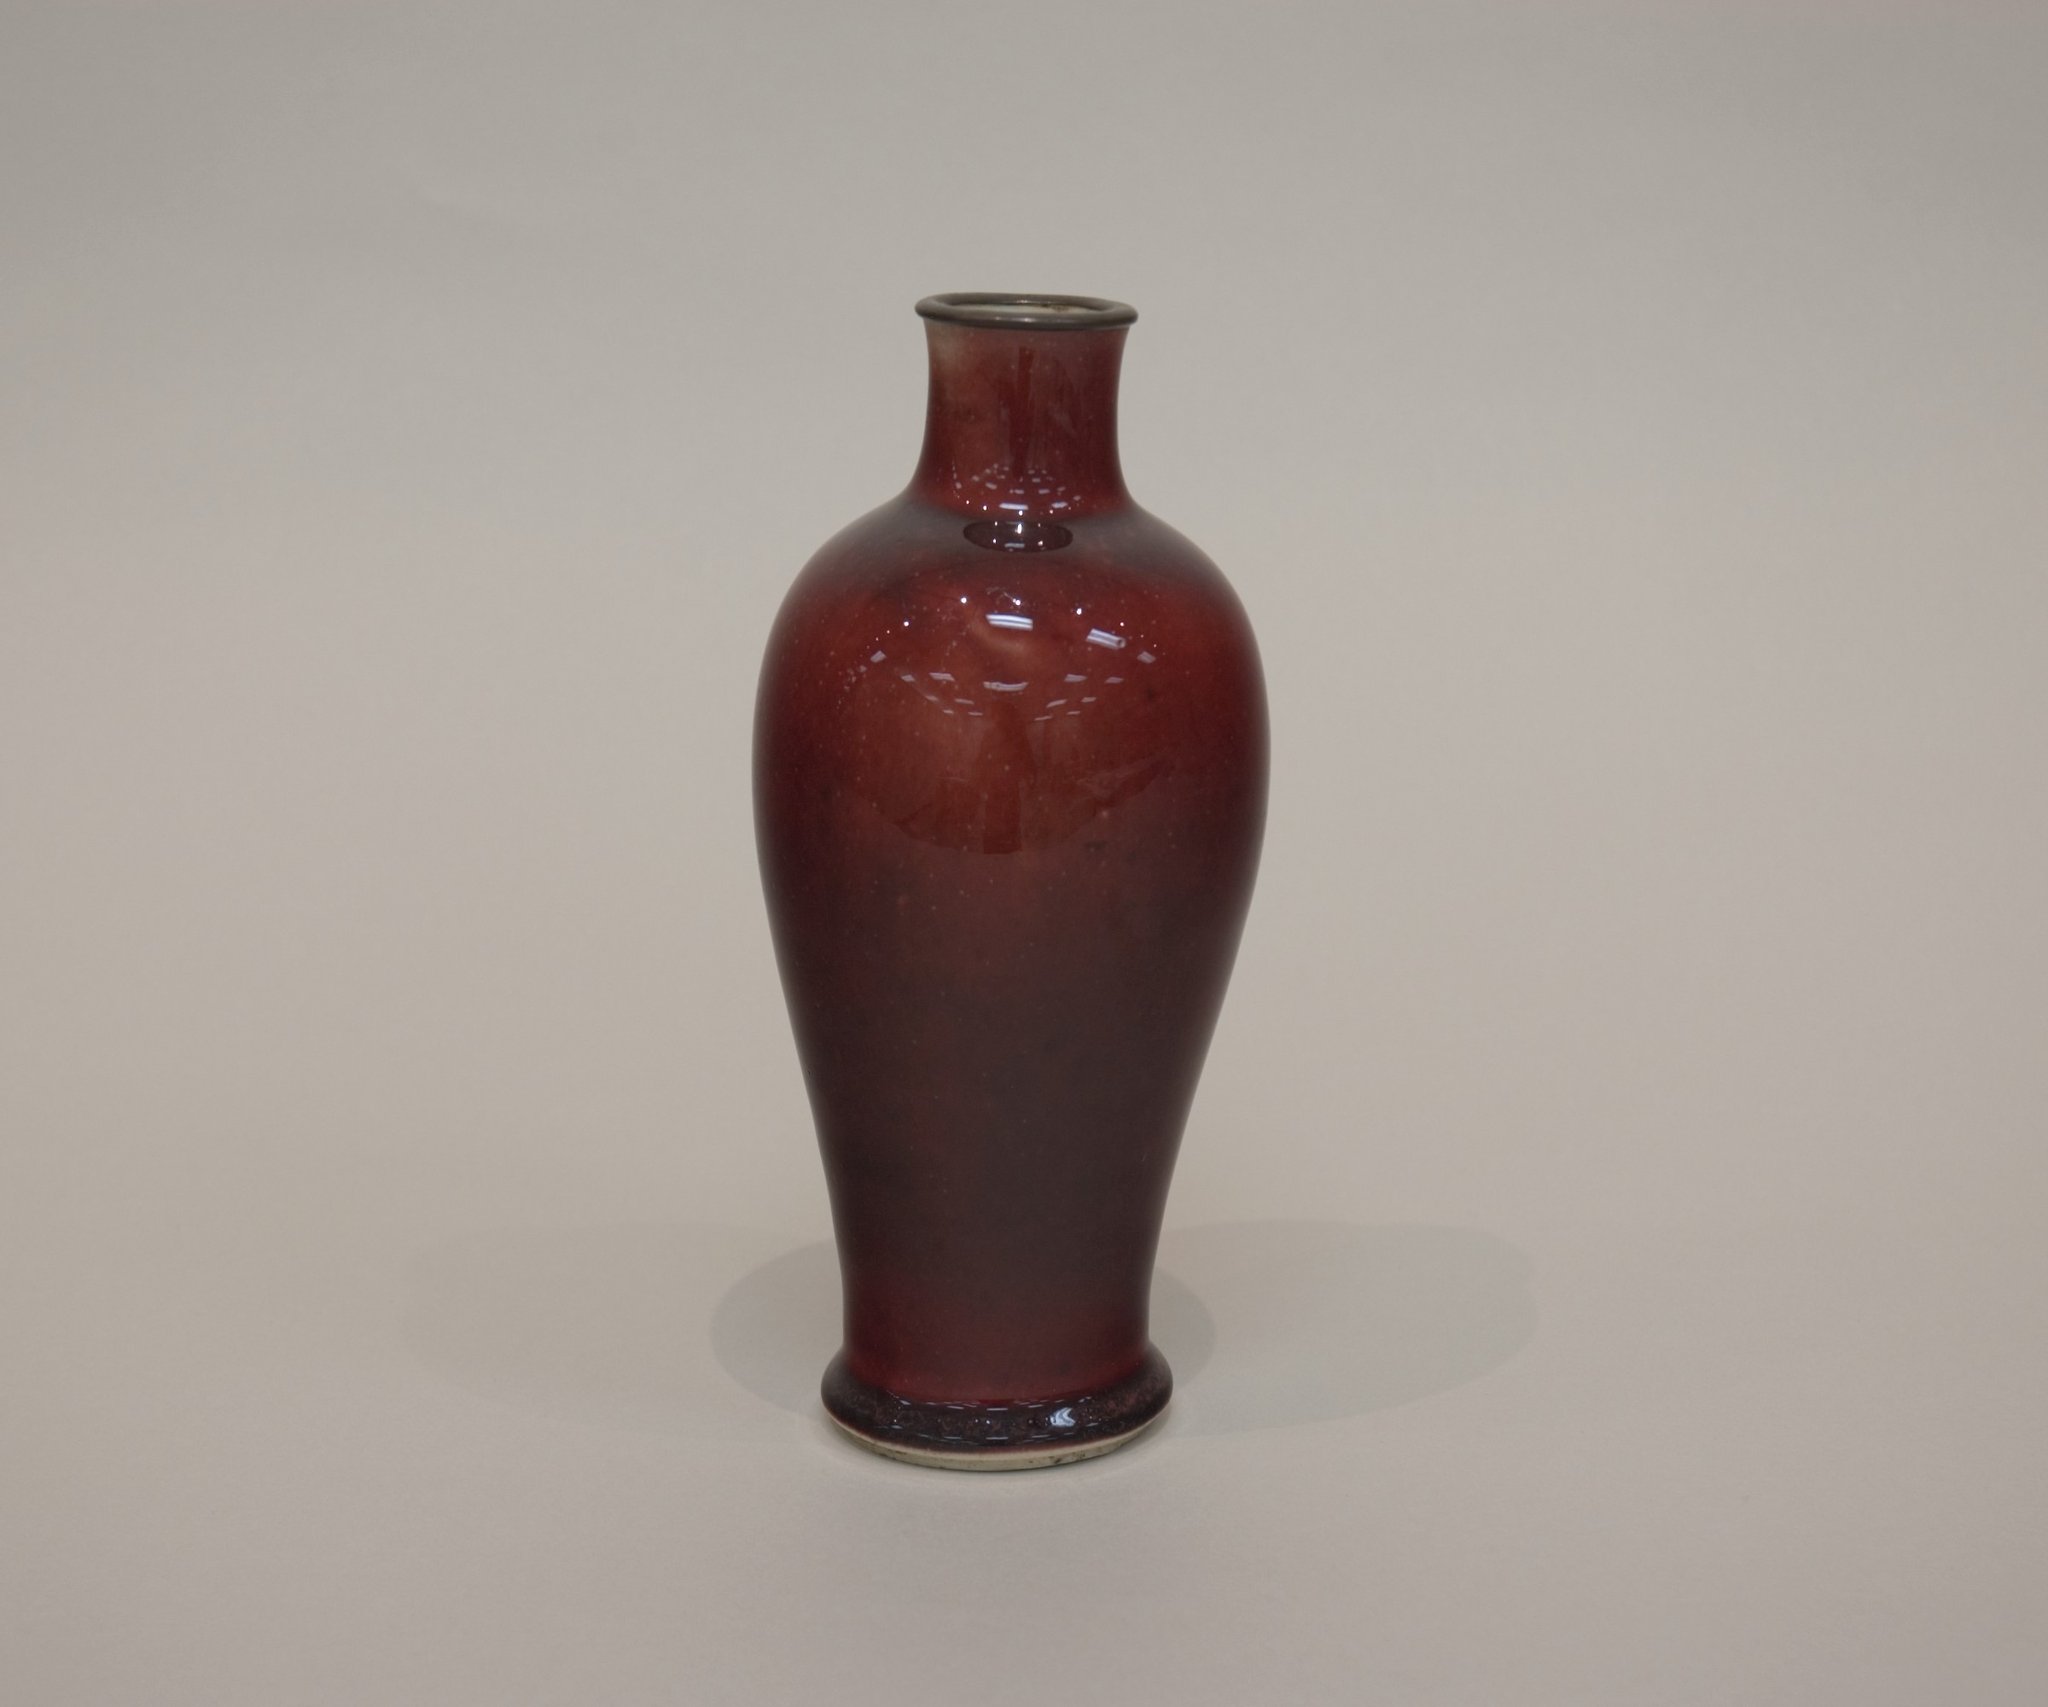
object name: vase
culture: chinese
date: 1667-1733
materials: copper, glaze, porcelain